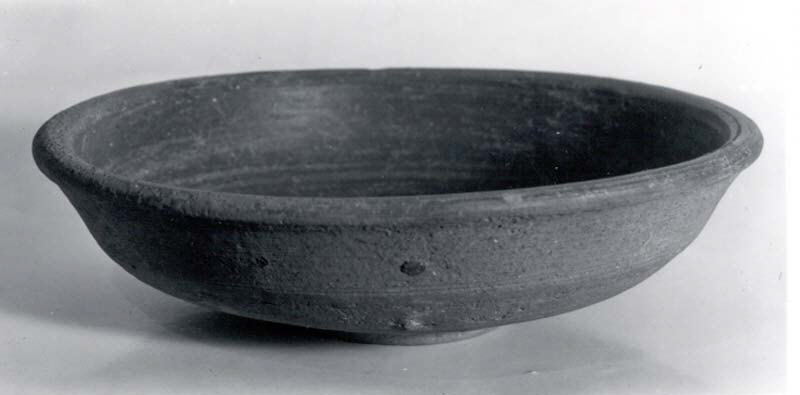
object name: bowl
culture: israelite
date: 734-601 BCE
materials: ceramic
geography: levant